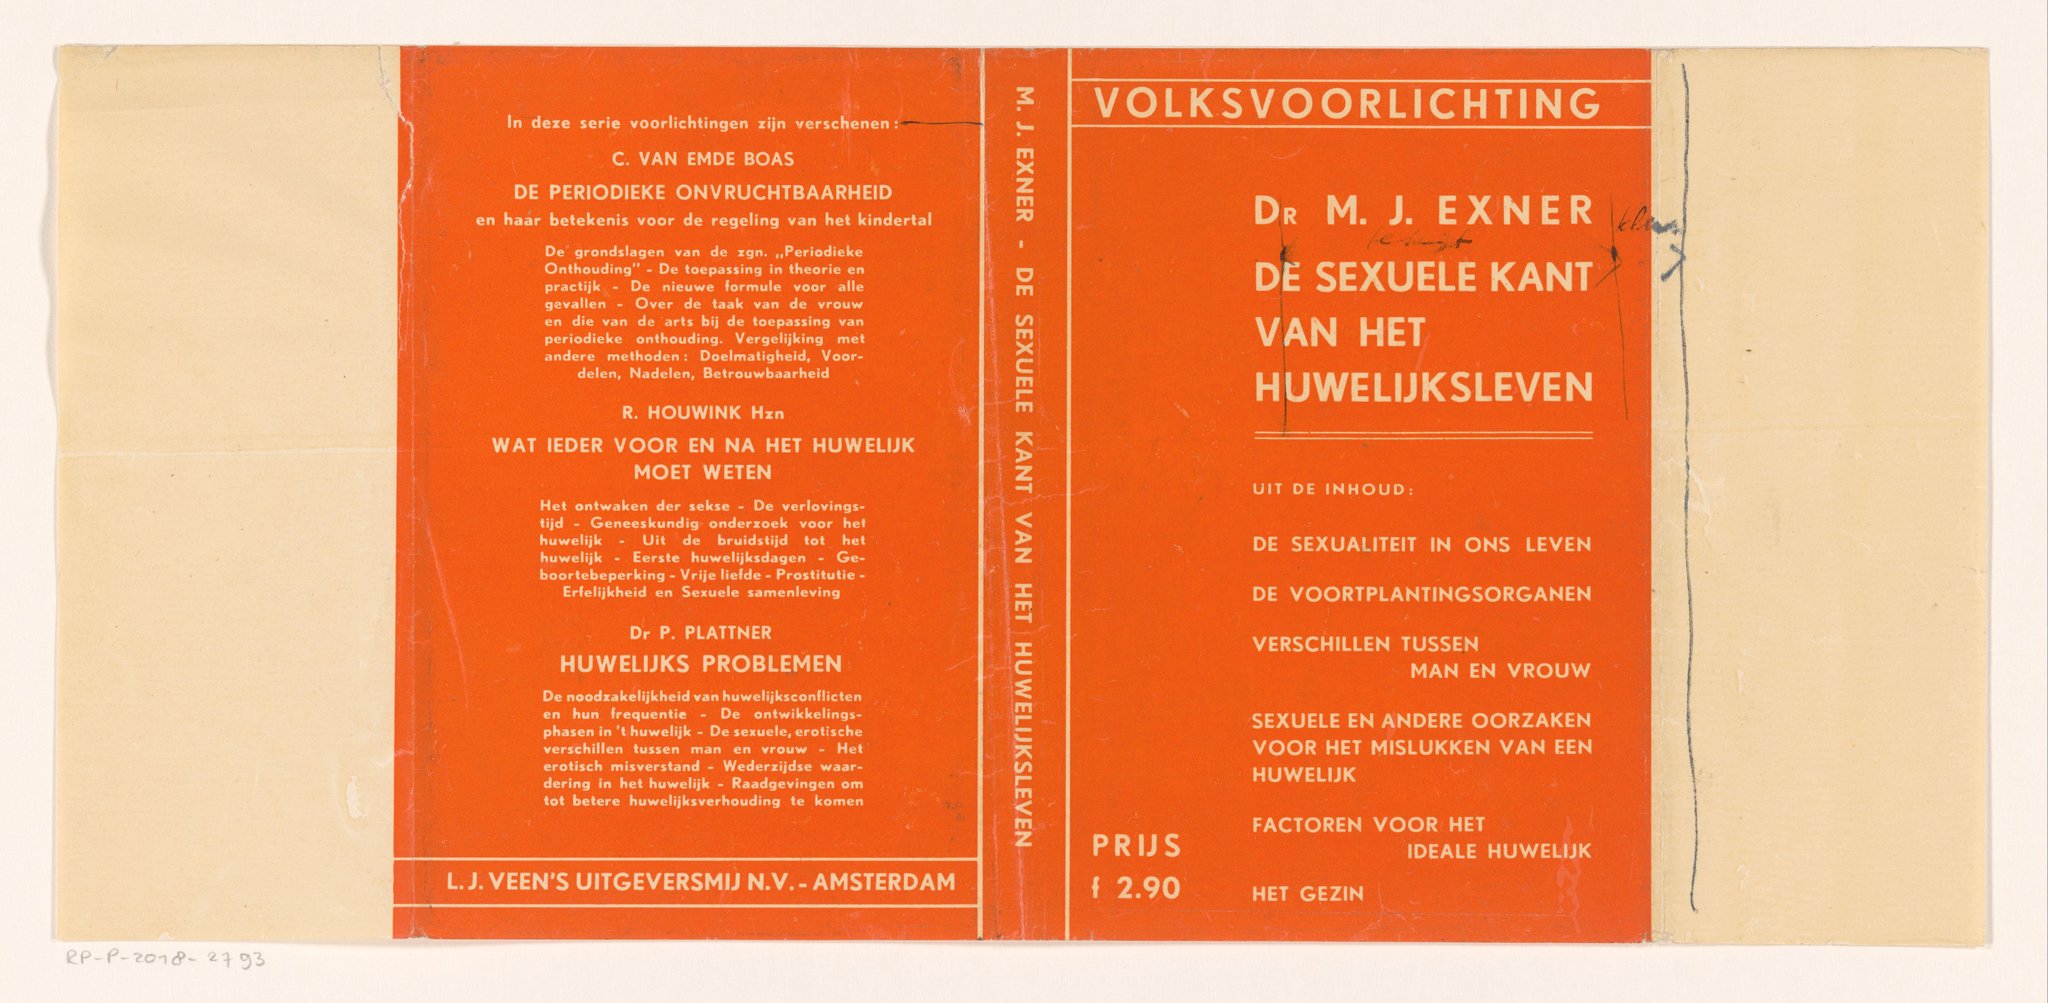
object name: study for binding design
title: Bandontwerp voor: M.J. Exner, De sexuele kant van het huwelijksleven (The sexual side of marriage), 1952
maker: Anonymous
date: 1952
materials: paper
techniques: printing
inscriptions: clichéaanwijzing, recto, handgeschreven